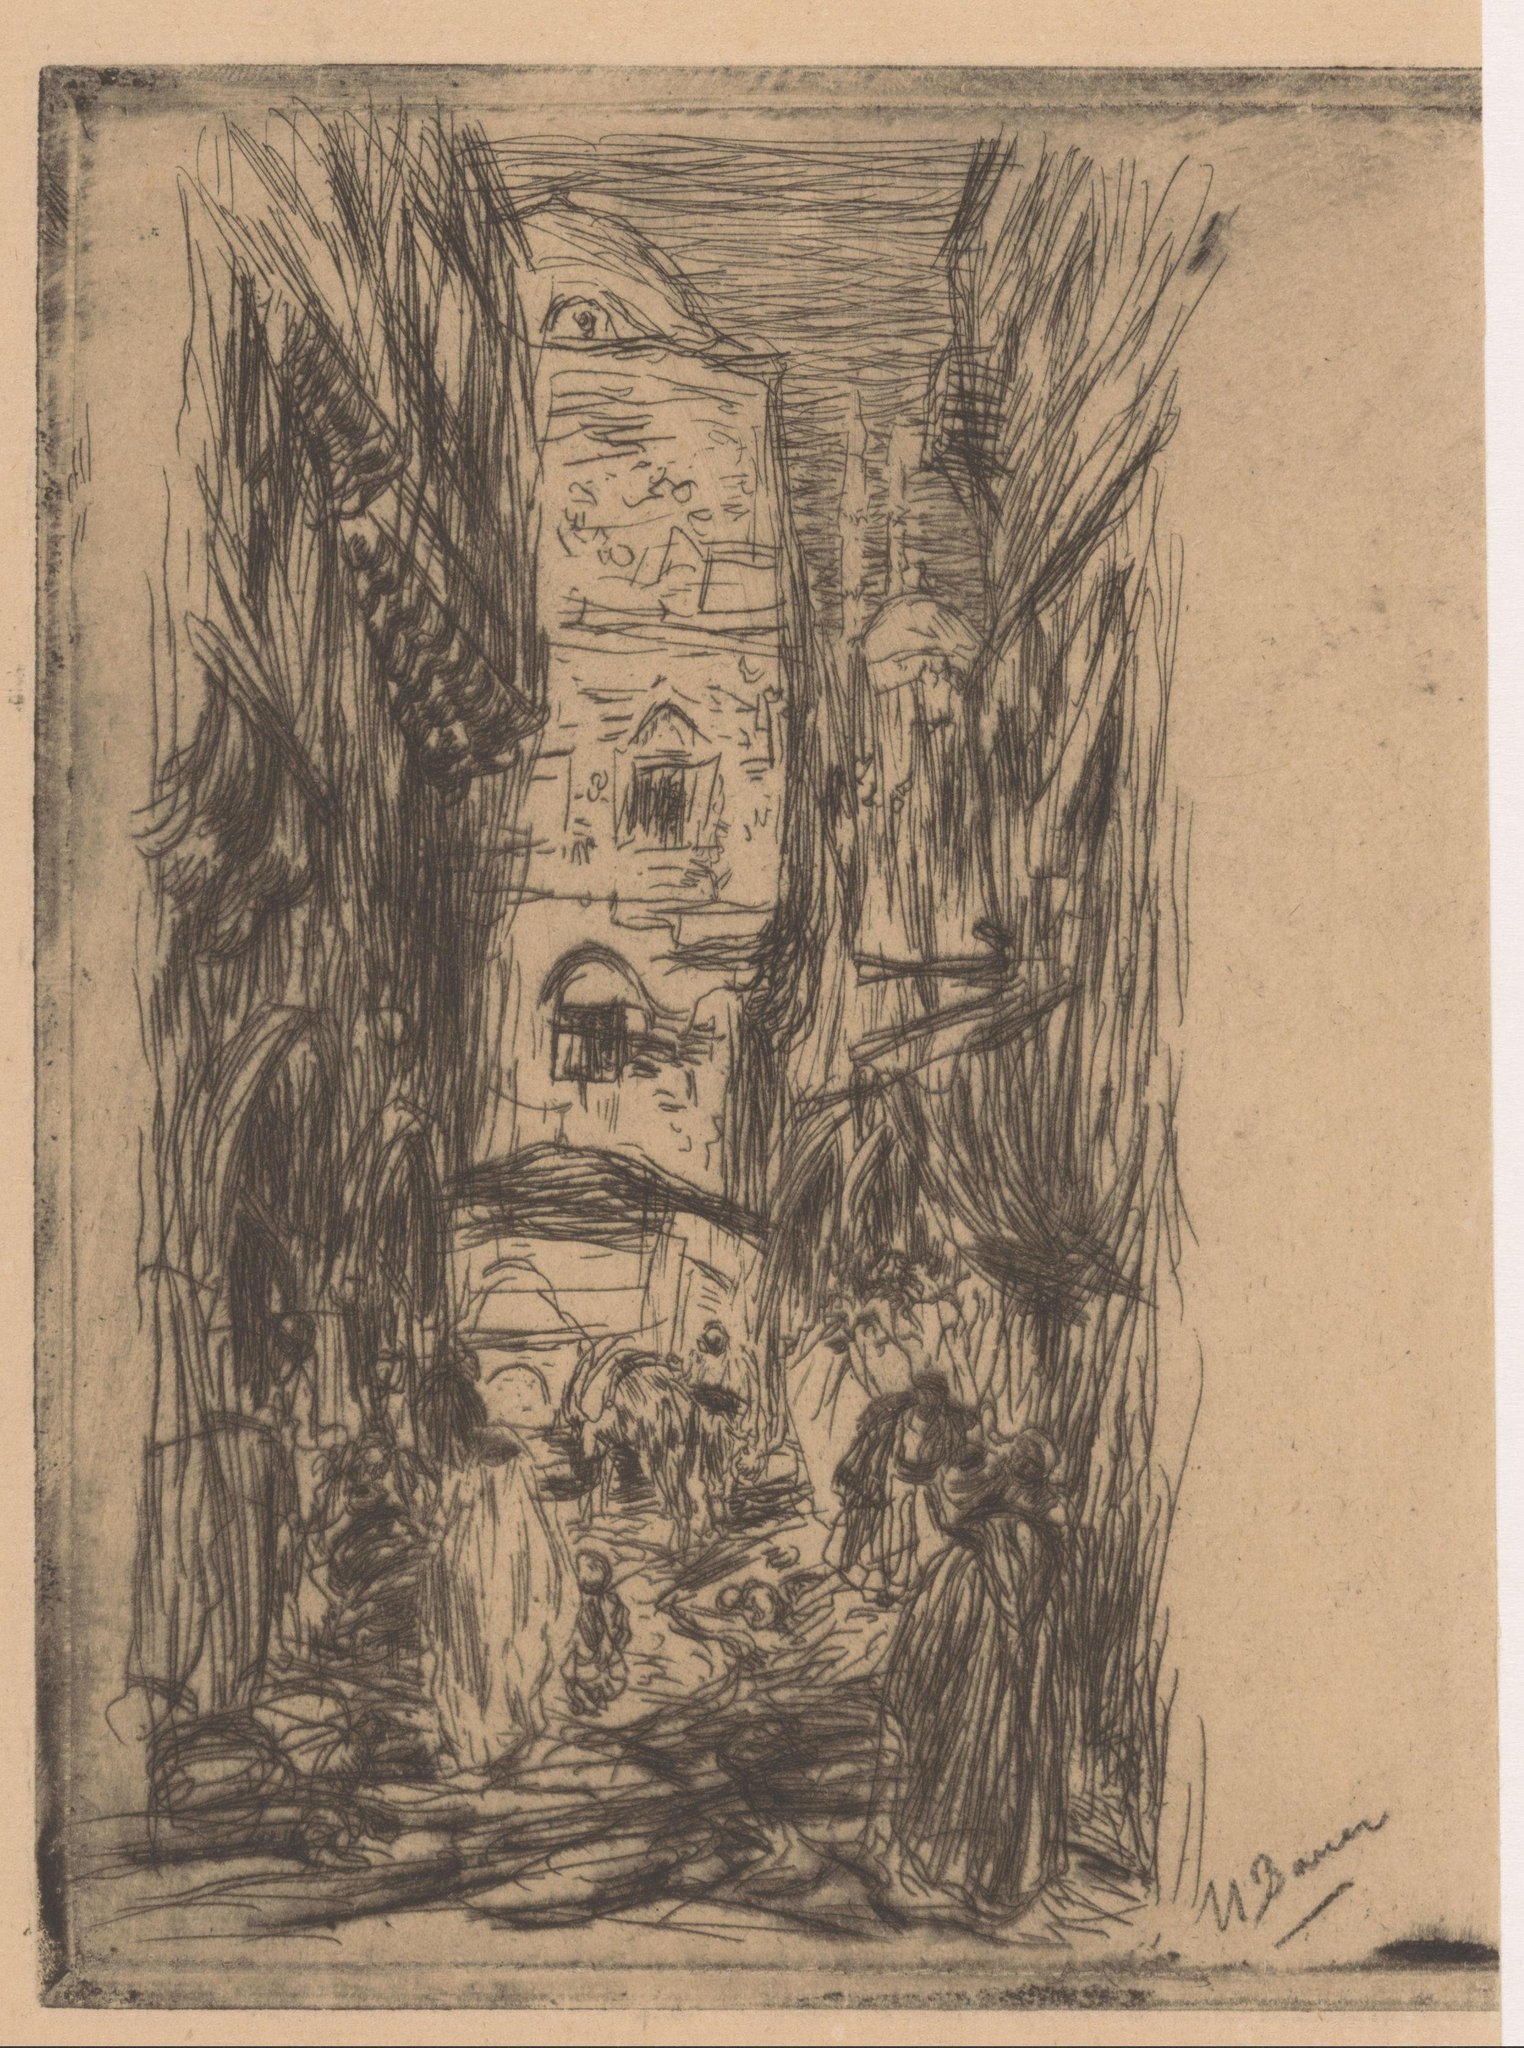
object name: print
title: Straat in Constantinopel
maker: marius bauer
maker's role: draughtsman, print maker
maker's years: 1867-1932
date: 1888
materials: paper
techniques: etching, intaglio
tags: temple, shrine ~ islam, mohammedanism, street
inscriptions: collector's mark: Lugt 2228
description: Een straat met mensen in oosterse kleding. Rechts op de achtergrond twee minaretten van een moskee.